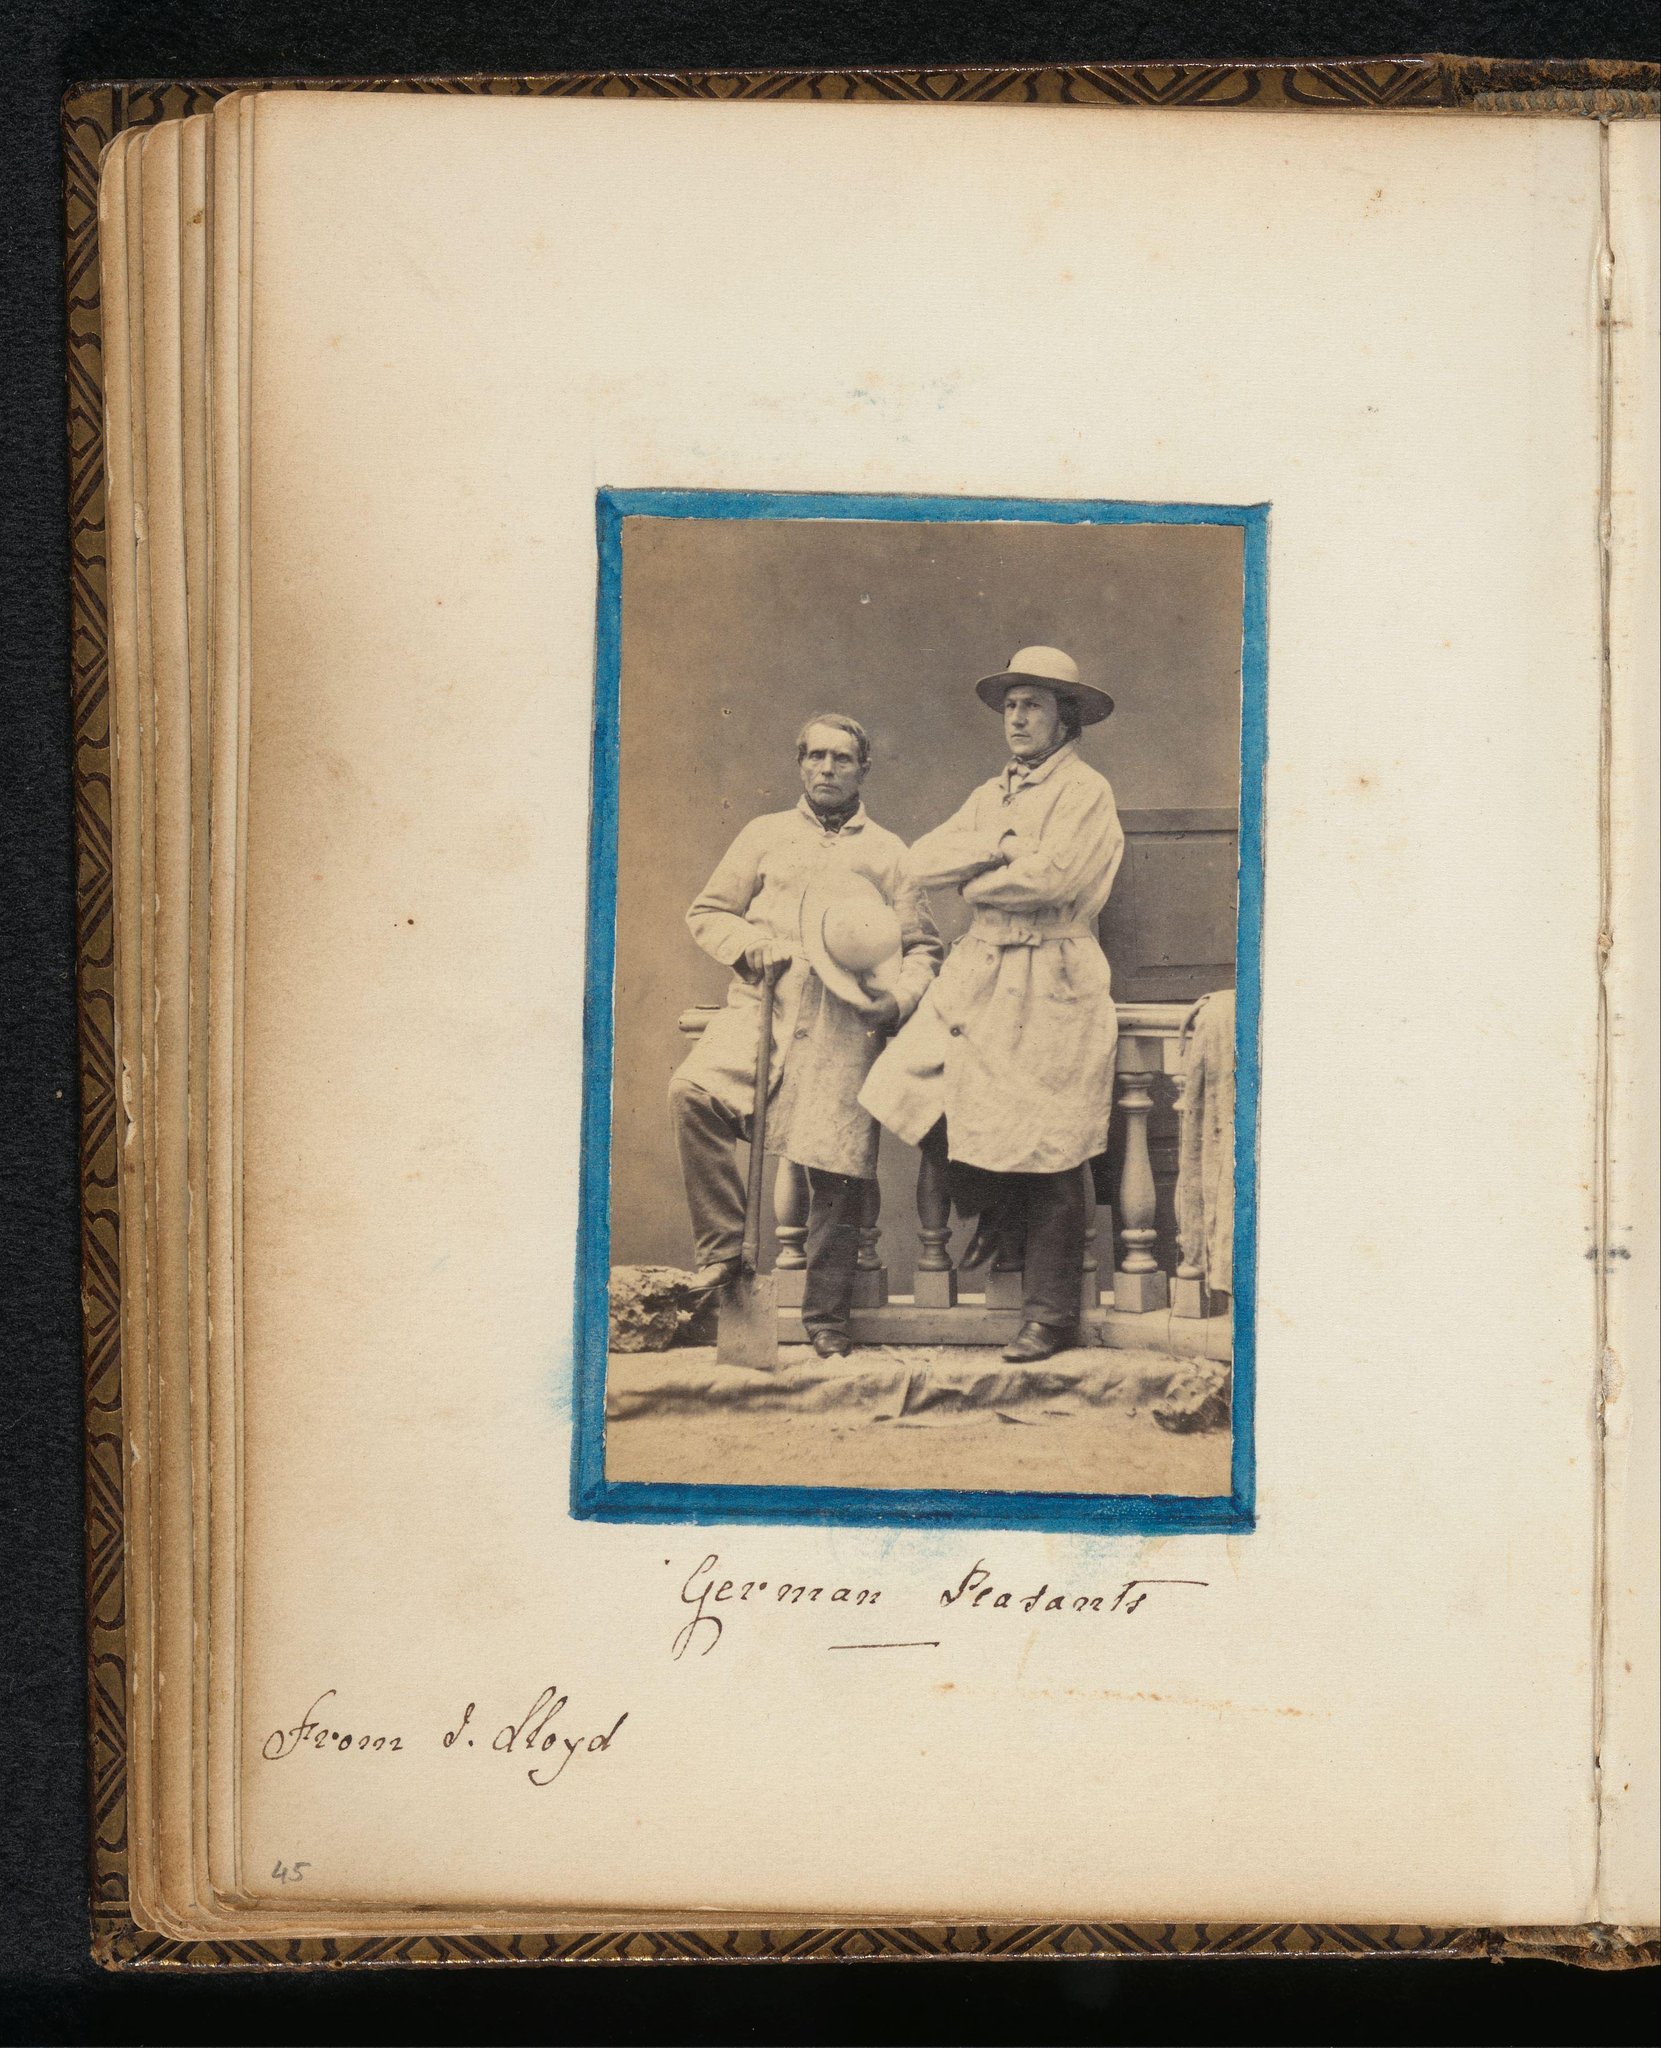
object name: photograph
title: German Peasants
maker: Anonymous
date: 1865-1867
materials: cardboard, photographic support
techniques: albumen print, aquarelle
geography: england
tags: farmers, germany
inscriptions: annotation: ‘German Peasants / from: J. Lloyd’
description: Twee Duitse boeren. Foto op albumblad in album met 68 foto's merendeels met geaquarelleerde randversieringen. Het zijn voornamelijk portretten op carte-de-visite formaat.